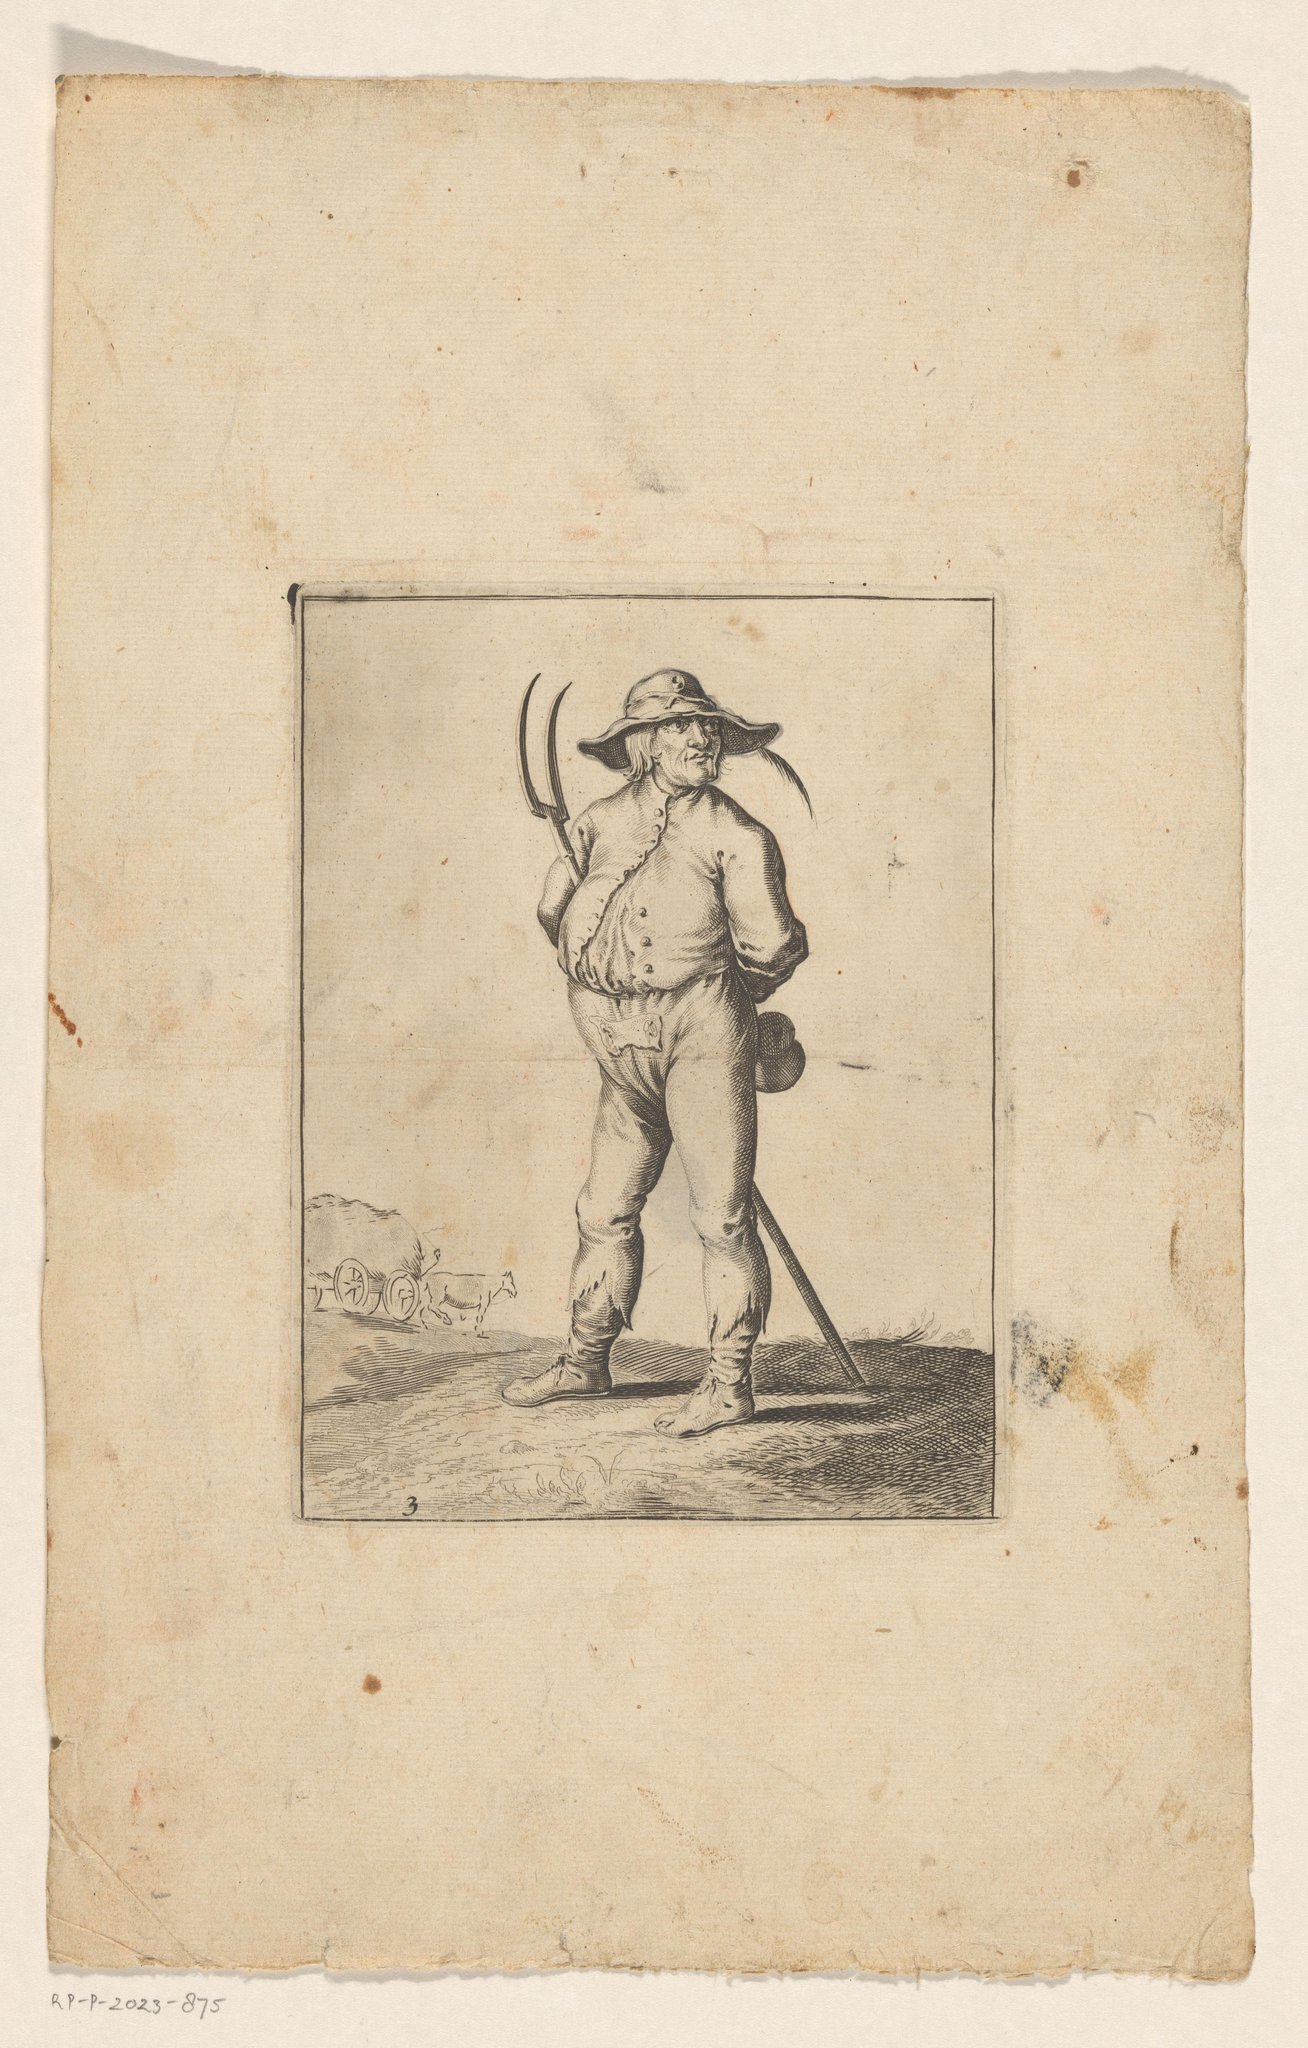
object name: print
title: Staande boer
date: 1650-1750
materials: paper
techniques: engraving, etching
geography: amsterdam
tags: farmers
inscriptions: collector's mark: Lugt 2228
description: Staande boer met hooivork, de handen achter de rug. Op de achtergrond een hooiwagen. Linksonder genummerd: 3.